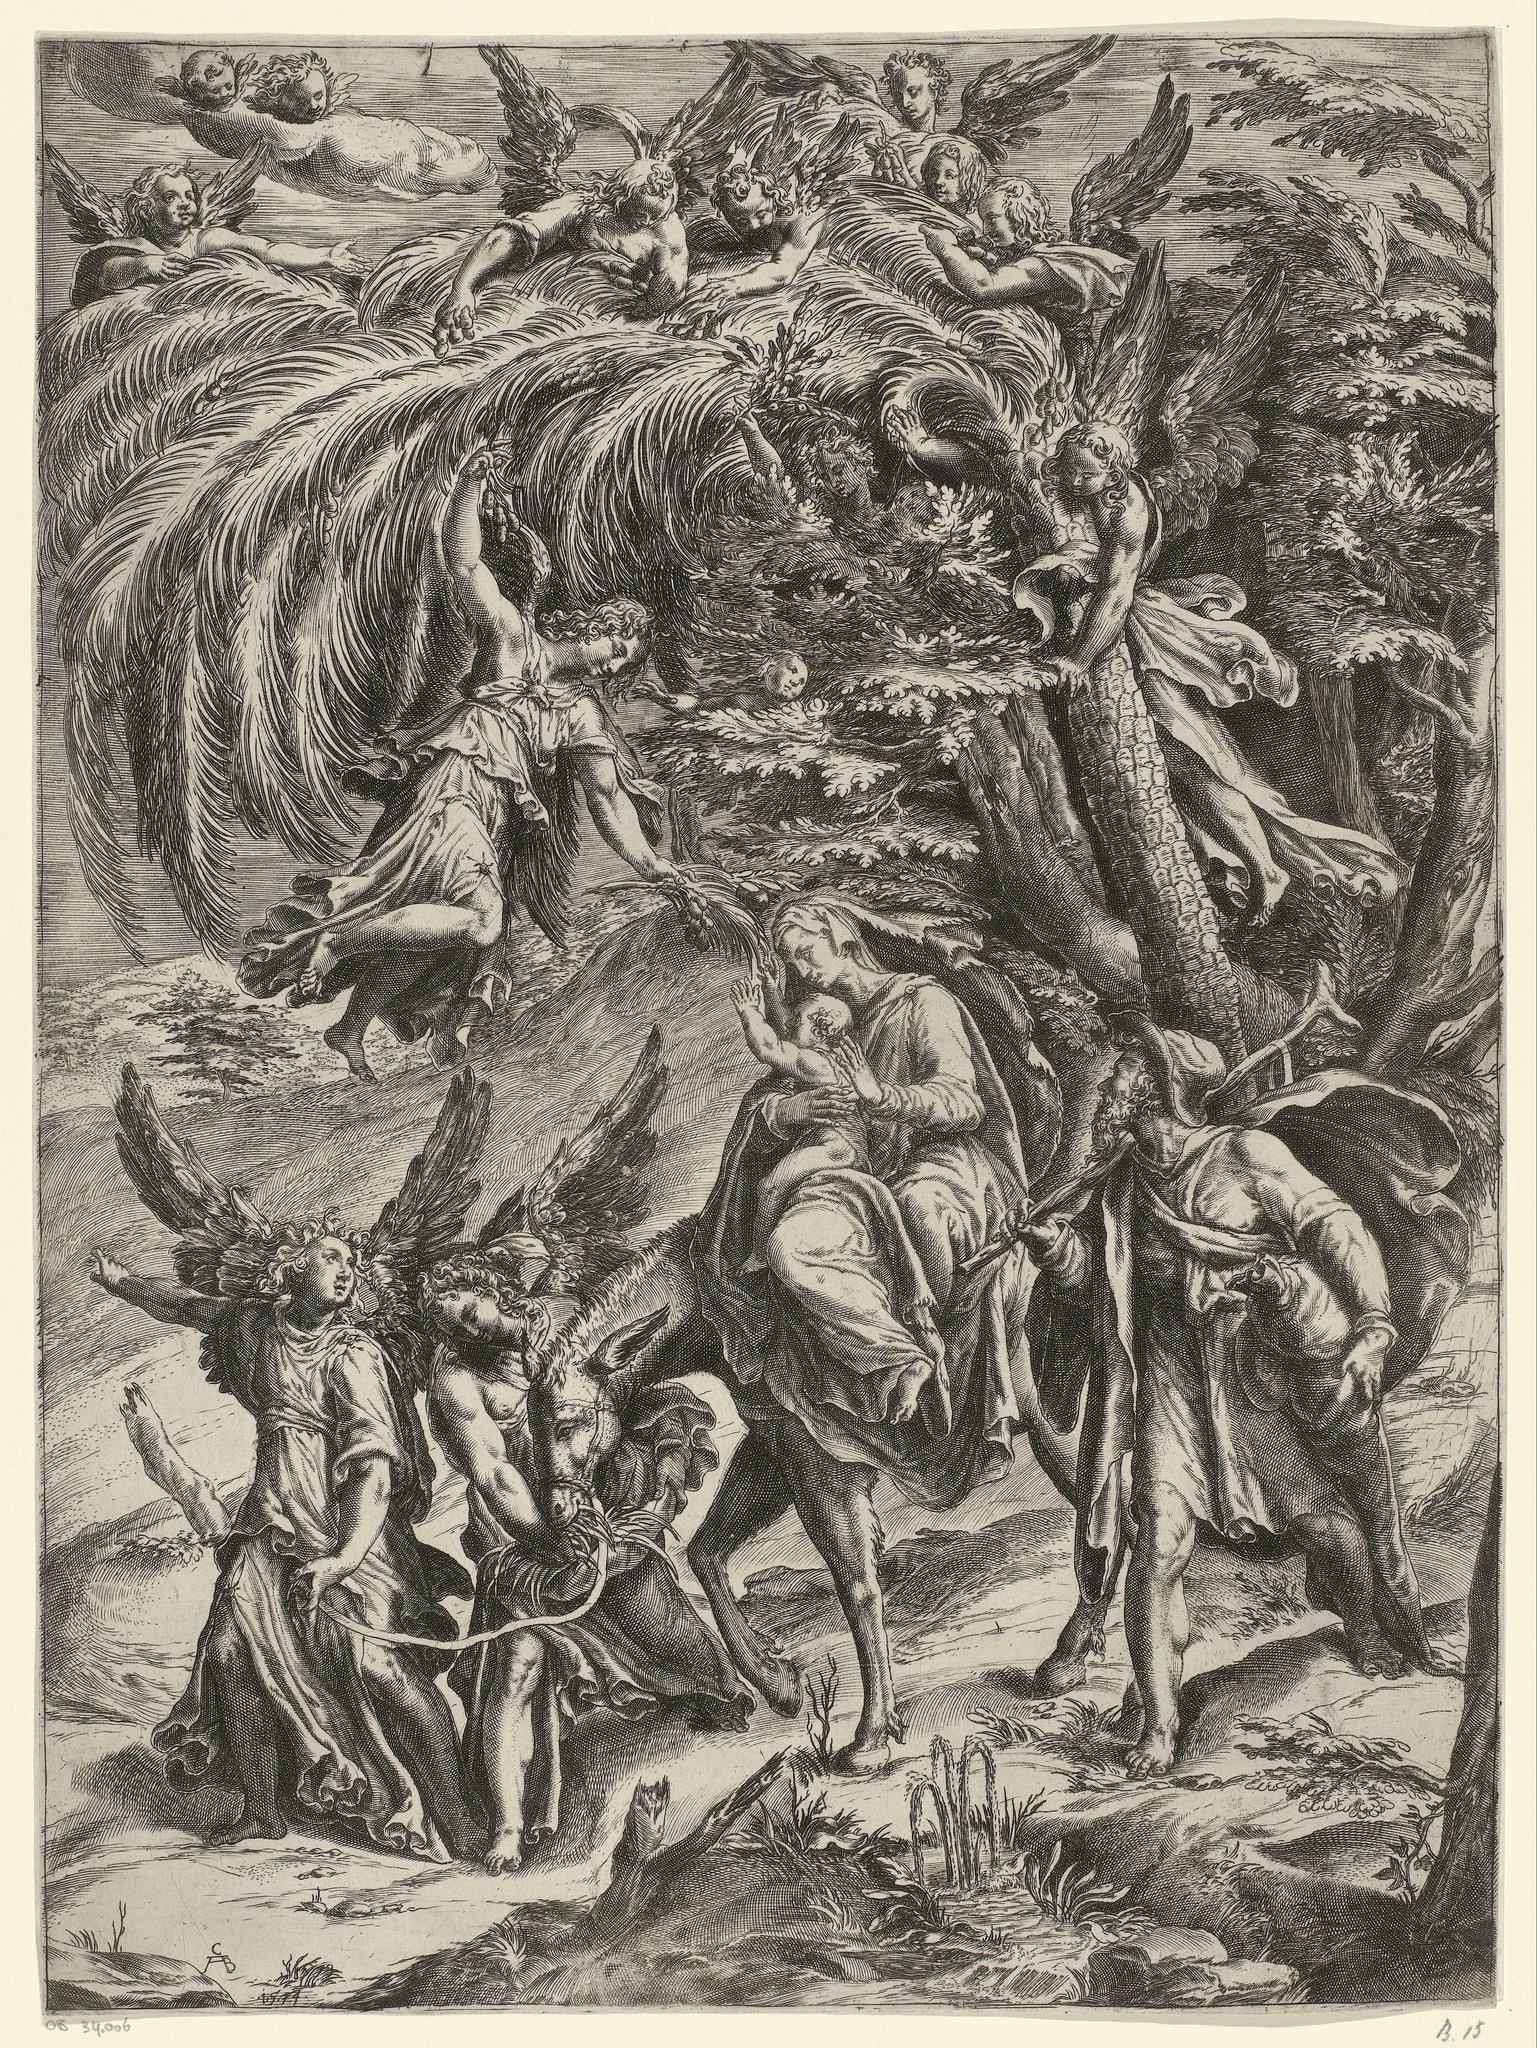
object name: print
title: Terugkeer van de vlucht naar Egypte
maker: cherubino alberti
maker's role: draughtsman, print maker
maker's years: 1553-1615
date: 1574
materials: paper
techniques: engraving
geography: italy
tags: the holy family (and sometimes others) returning to israel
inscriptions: date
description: Maria met het Christuskind op een ezel. Jozef loopt ernaast. Twee engelen leiden de ezel. Boven tussen de takken van de bomen zweven engelen die vruchten plukken en deze aan Christus geven.